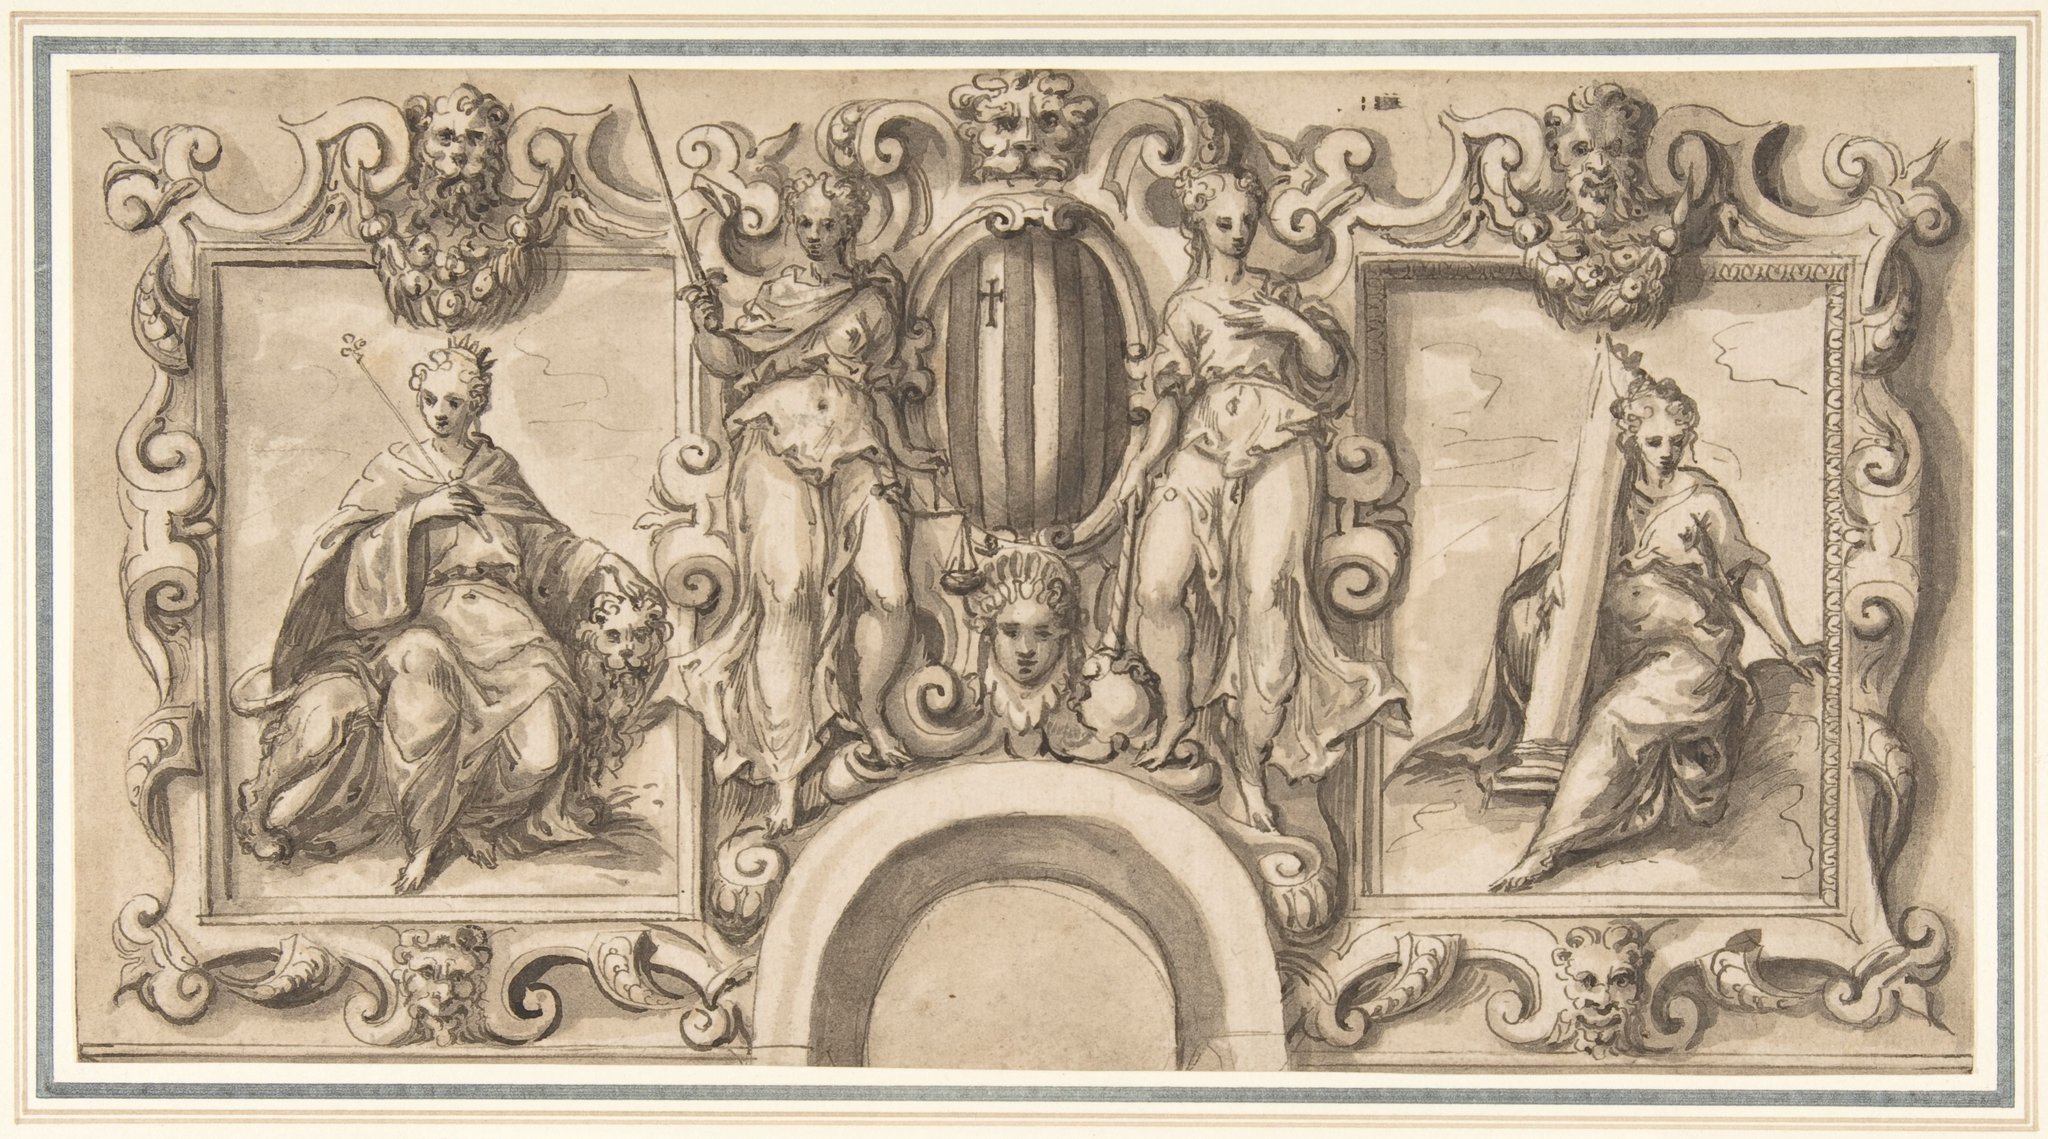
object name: drawing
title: Design for a Wall Decoration over an Arched Doorway with Grimani Arms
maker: bernardino india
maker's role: artist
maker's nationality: italian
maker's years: 1528-1590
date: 1528-1590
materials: ink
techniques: brush, pen, wash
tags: women,coat of arms